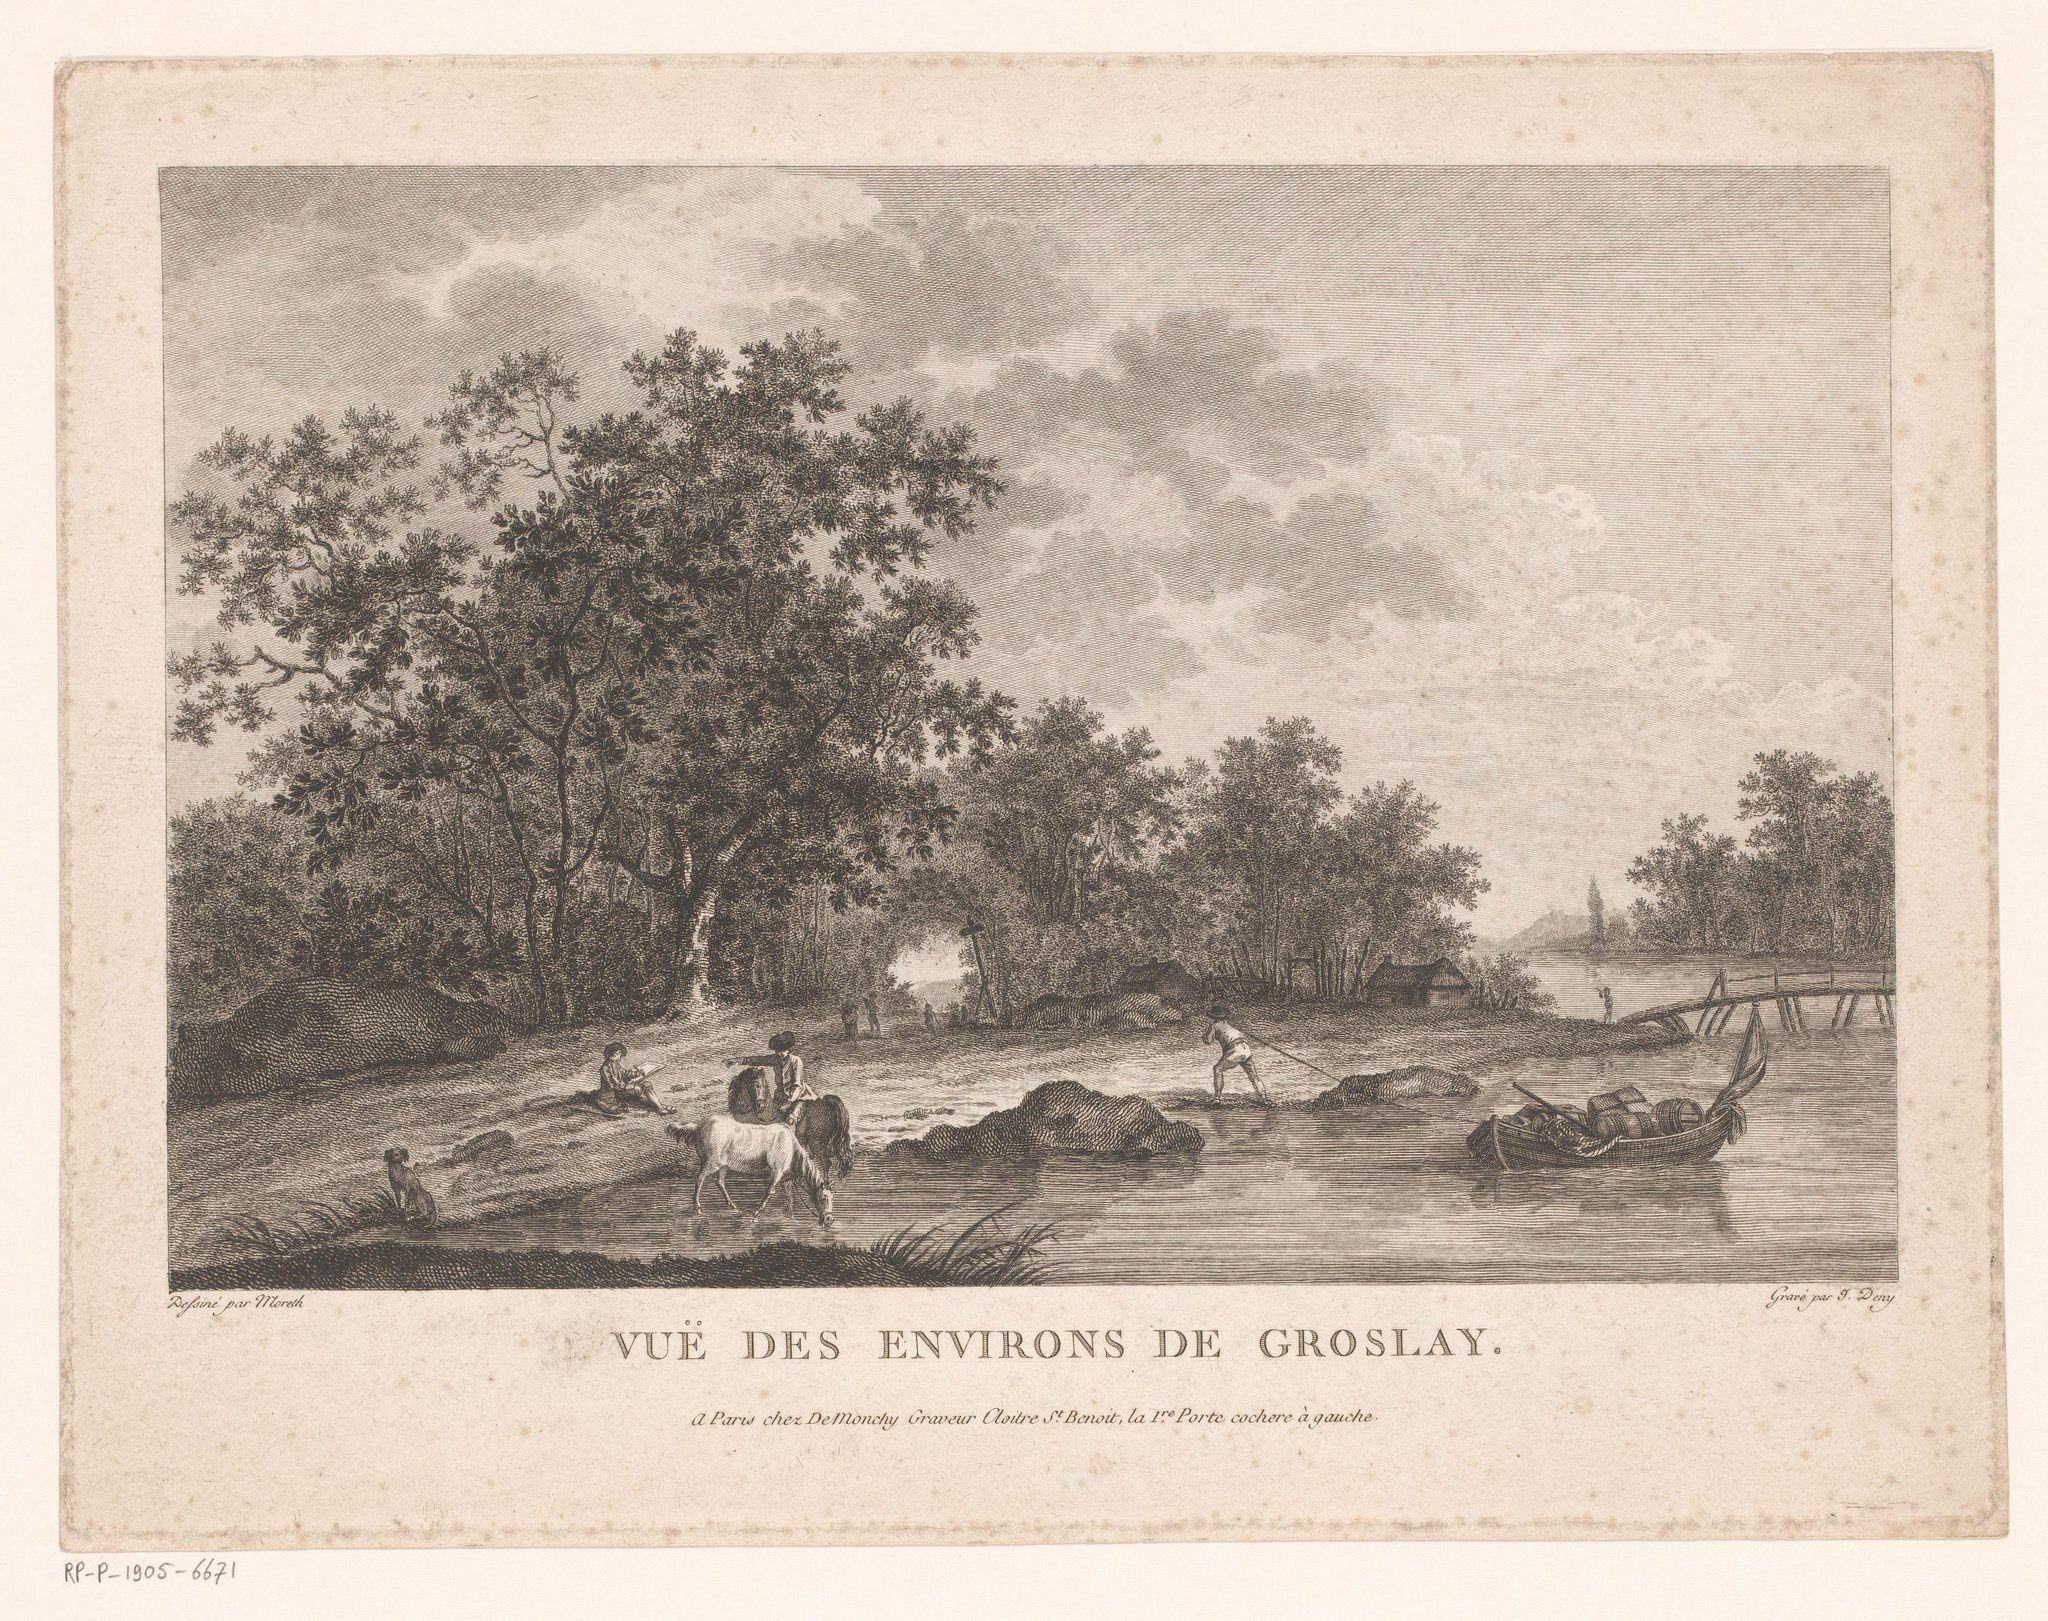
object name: print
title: Rivierlandschap met een brug en figuren langs de waterkant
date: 1759-1815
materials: paper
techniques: etching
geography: france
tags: landscapes with waters, waterscapes, seascapes (in the temperate zone), bridge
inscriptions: collector's mark: Lugt 2228